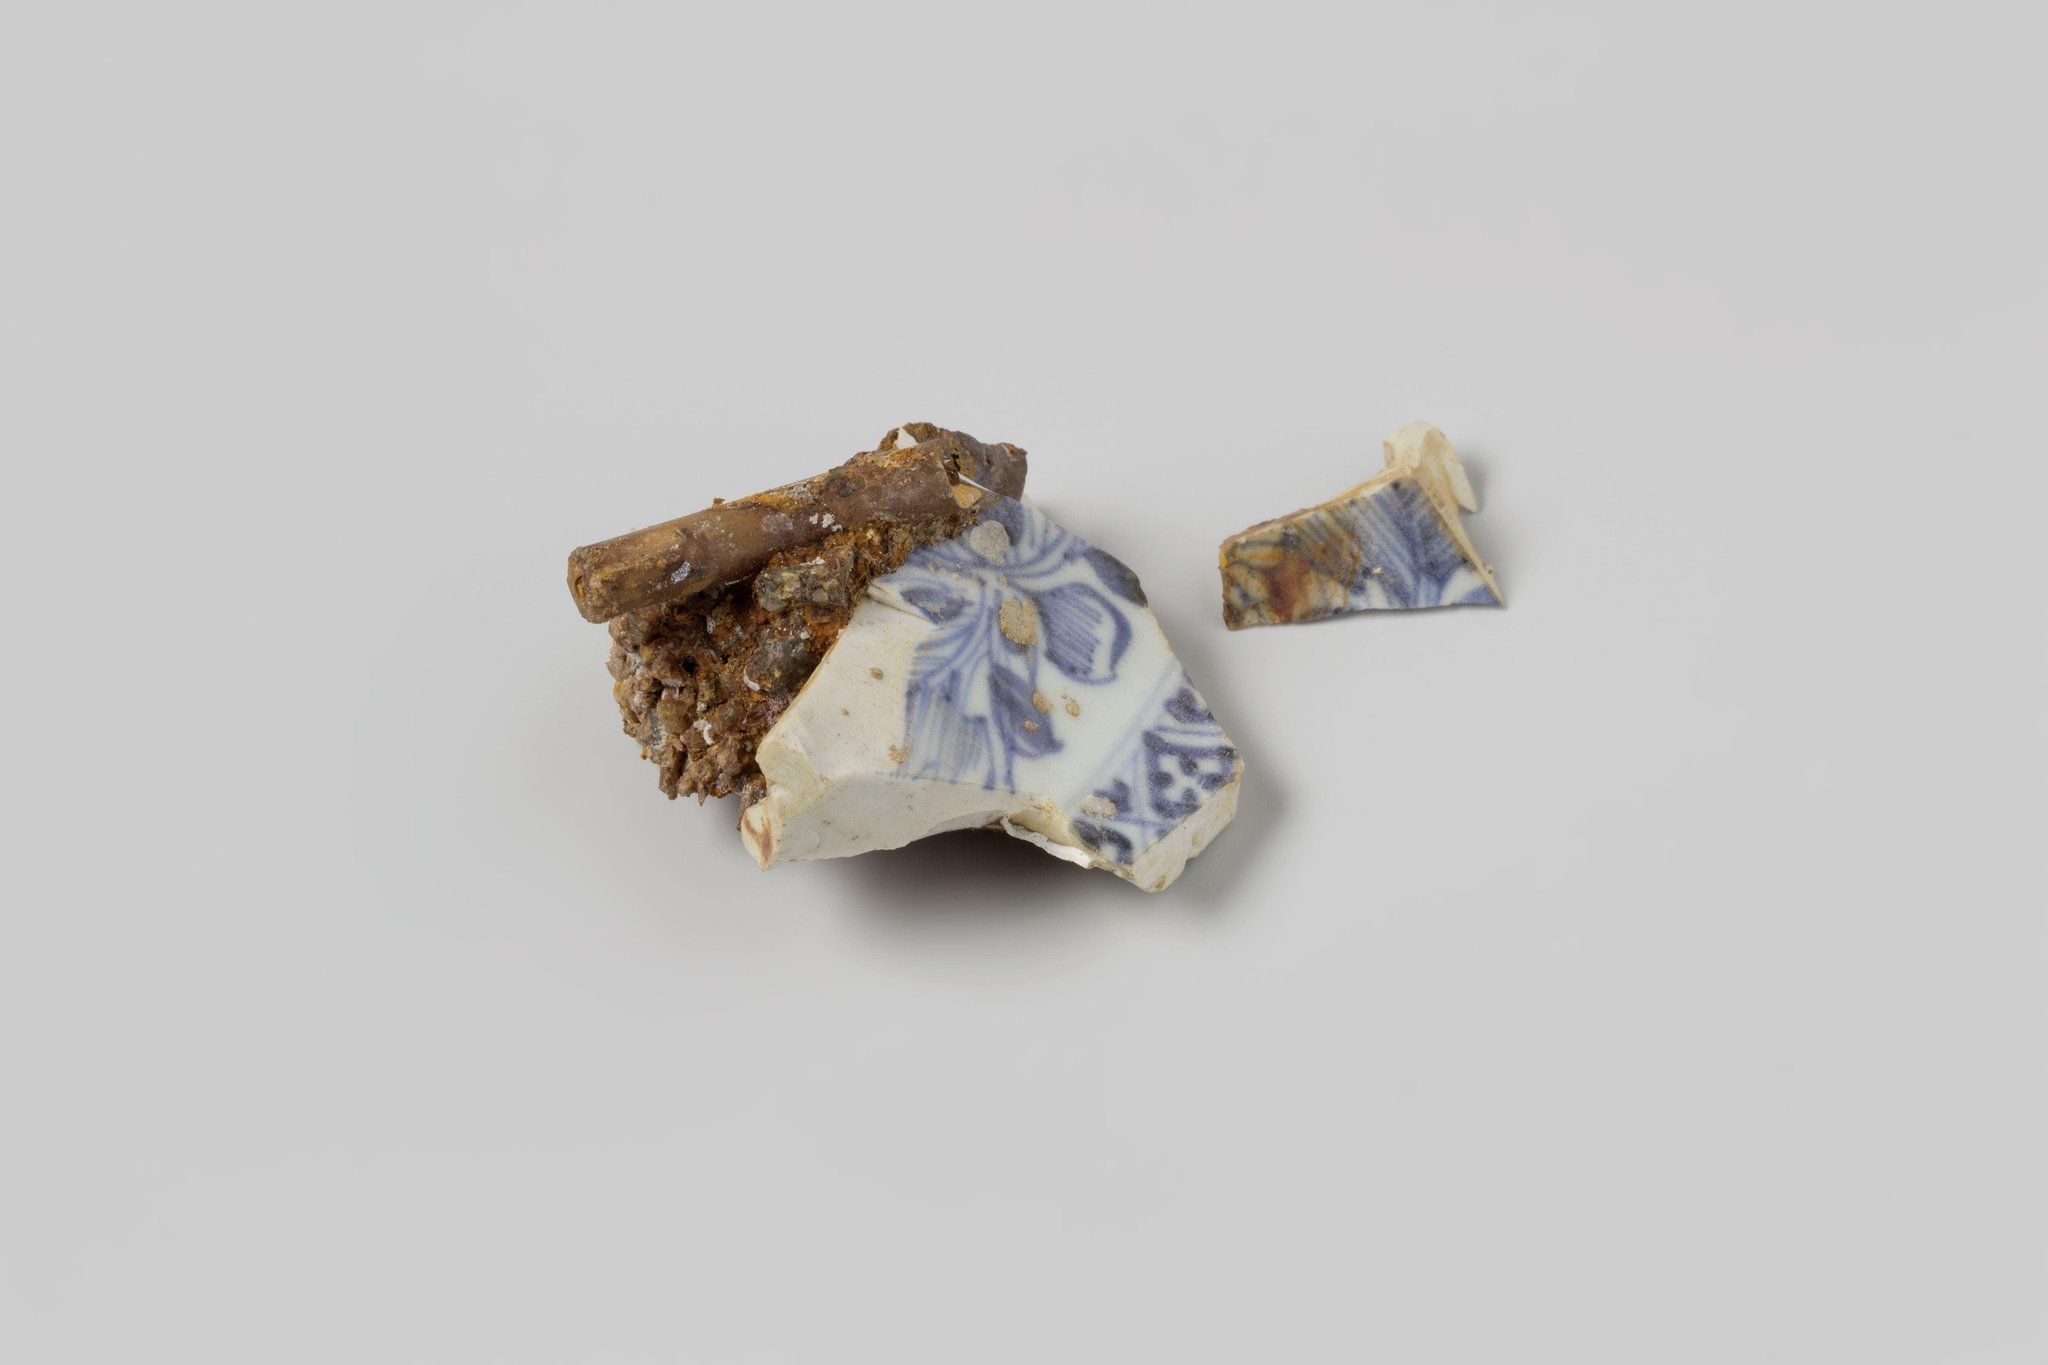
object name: sherd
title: Scherven van borden en een fragment pijpensteel in concretie uit het wrak van de Oost-Indiëvaarder Hollandia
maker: Anonymous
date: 1700-1743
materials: stone, clay, porcelain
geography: netherlands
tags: verenigde oostindische compagnie, hollandia (schip), annet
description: Porcelain, plate, type 2; fragm of base, sim. NG 1980-27H507.